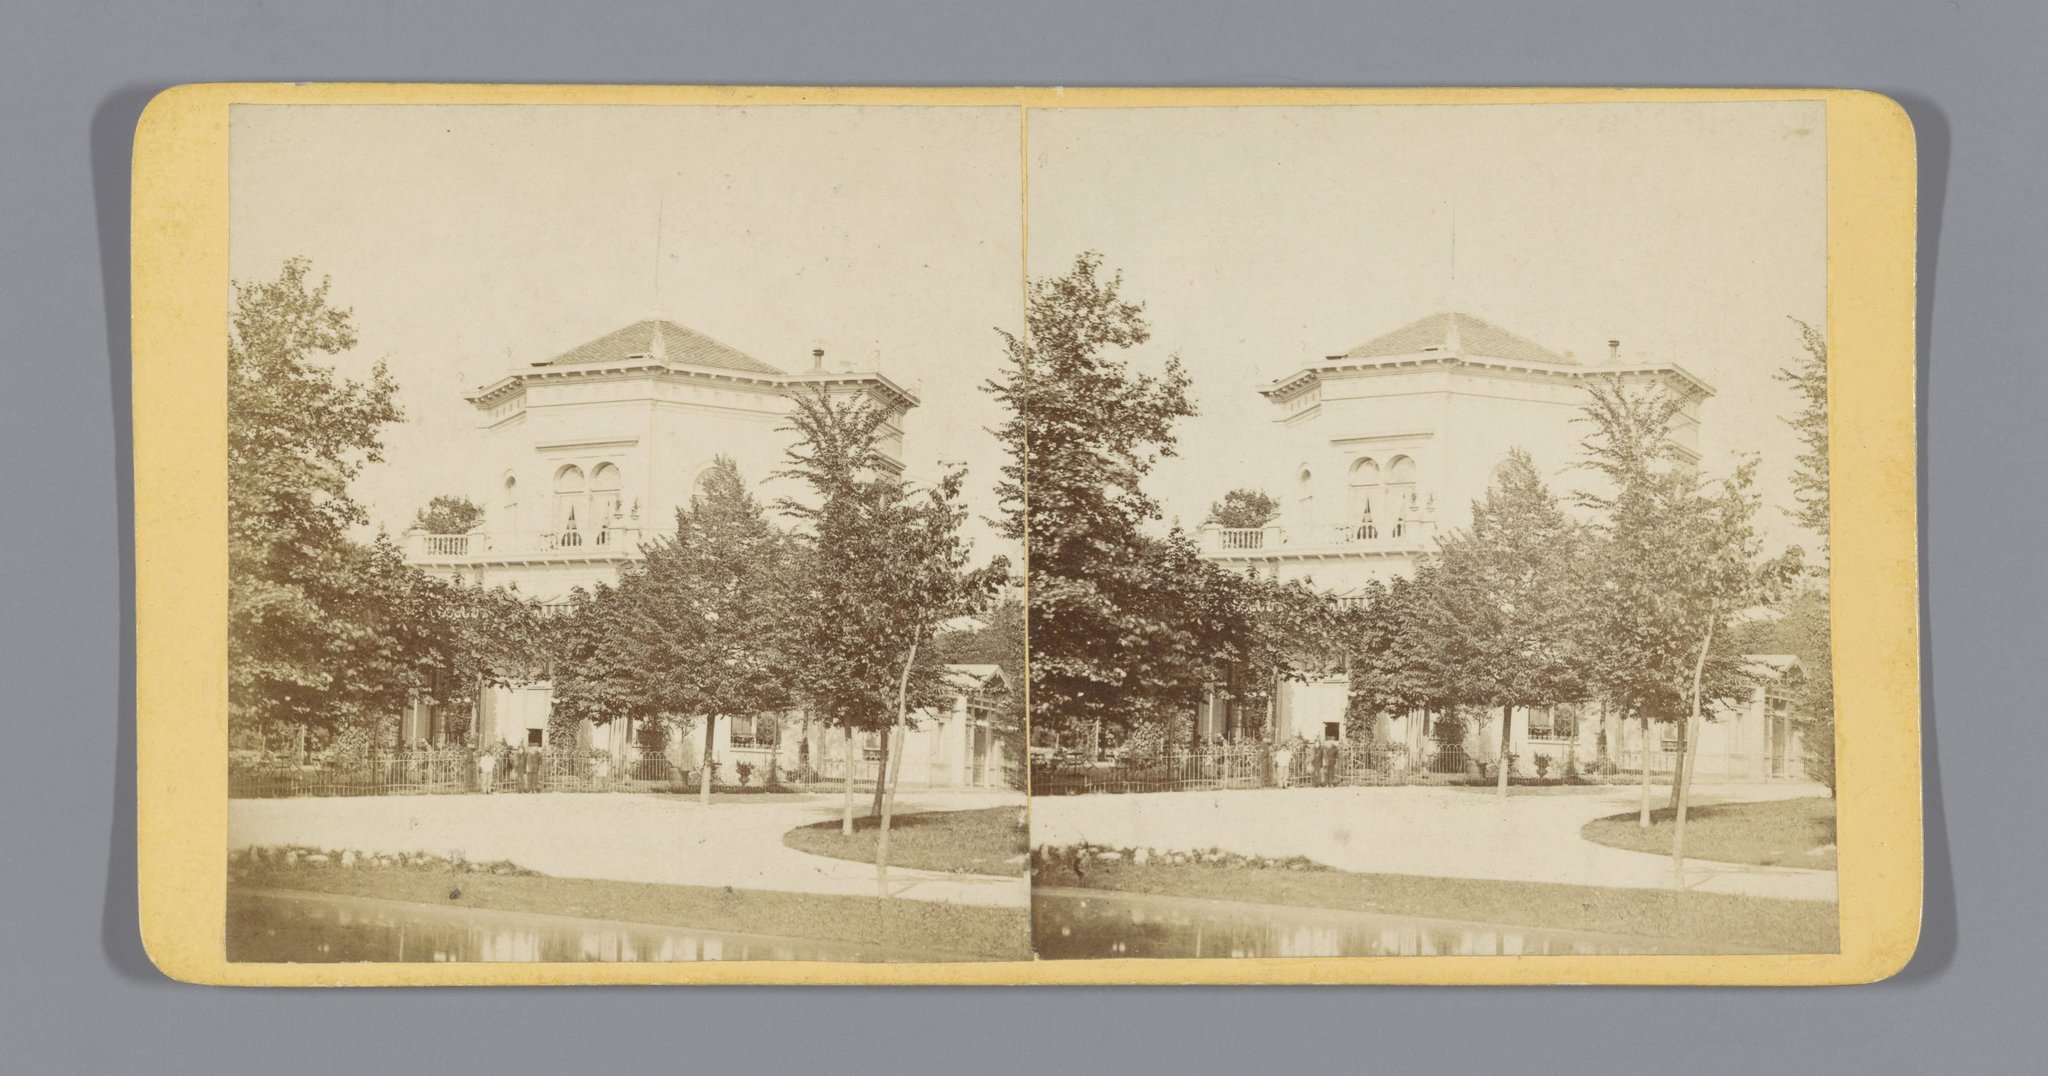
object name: stereograph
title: Villa bij een park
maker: Anonymous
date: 1868-1890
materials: cardboard, paper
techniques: albumen print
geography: europe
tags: villa, europe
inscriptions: number: ‘No 73’